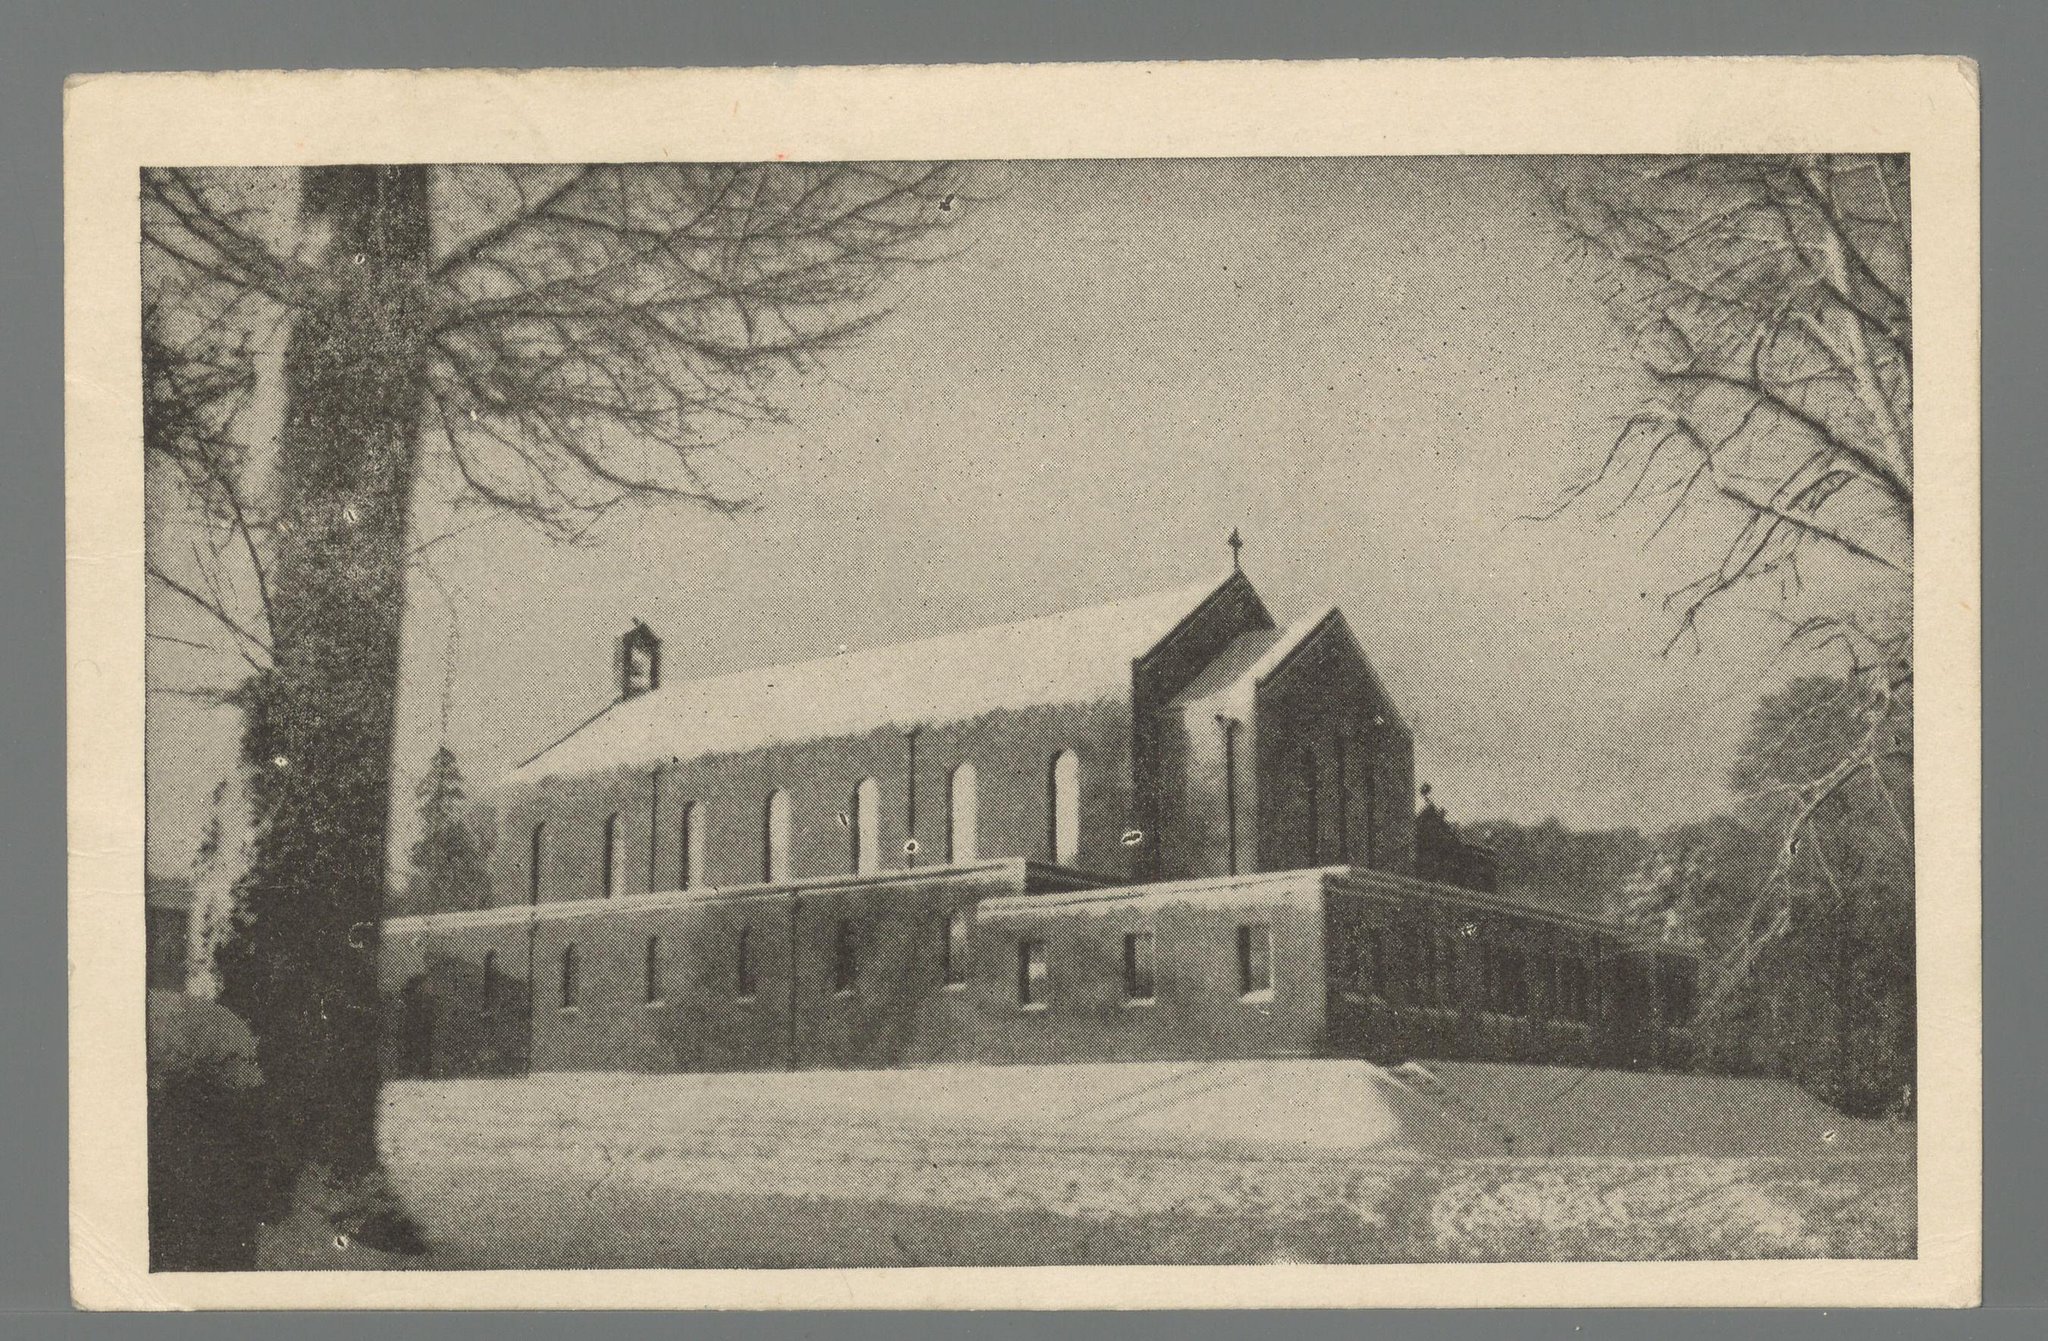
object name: ansichtkaart, prentbriefkaart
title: Gezicht op Saint Joseph’s College, Freshford, Country Kilkenny te Ierland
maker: Anonymous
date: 1915-1951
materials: cardboard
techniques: writing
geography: freshford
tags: university building, college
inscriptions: poststempel, verso, gestempeld